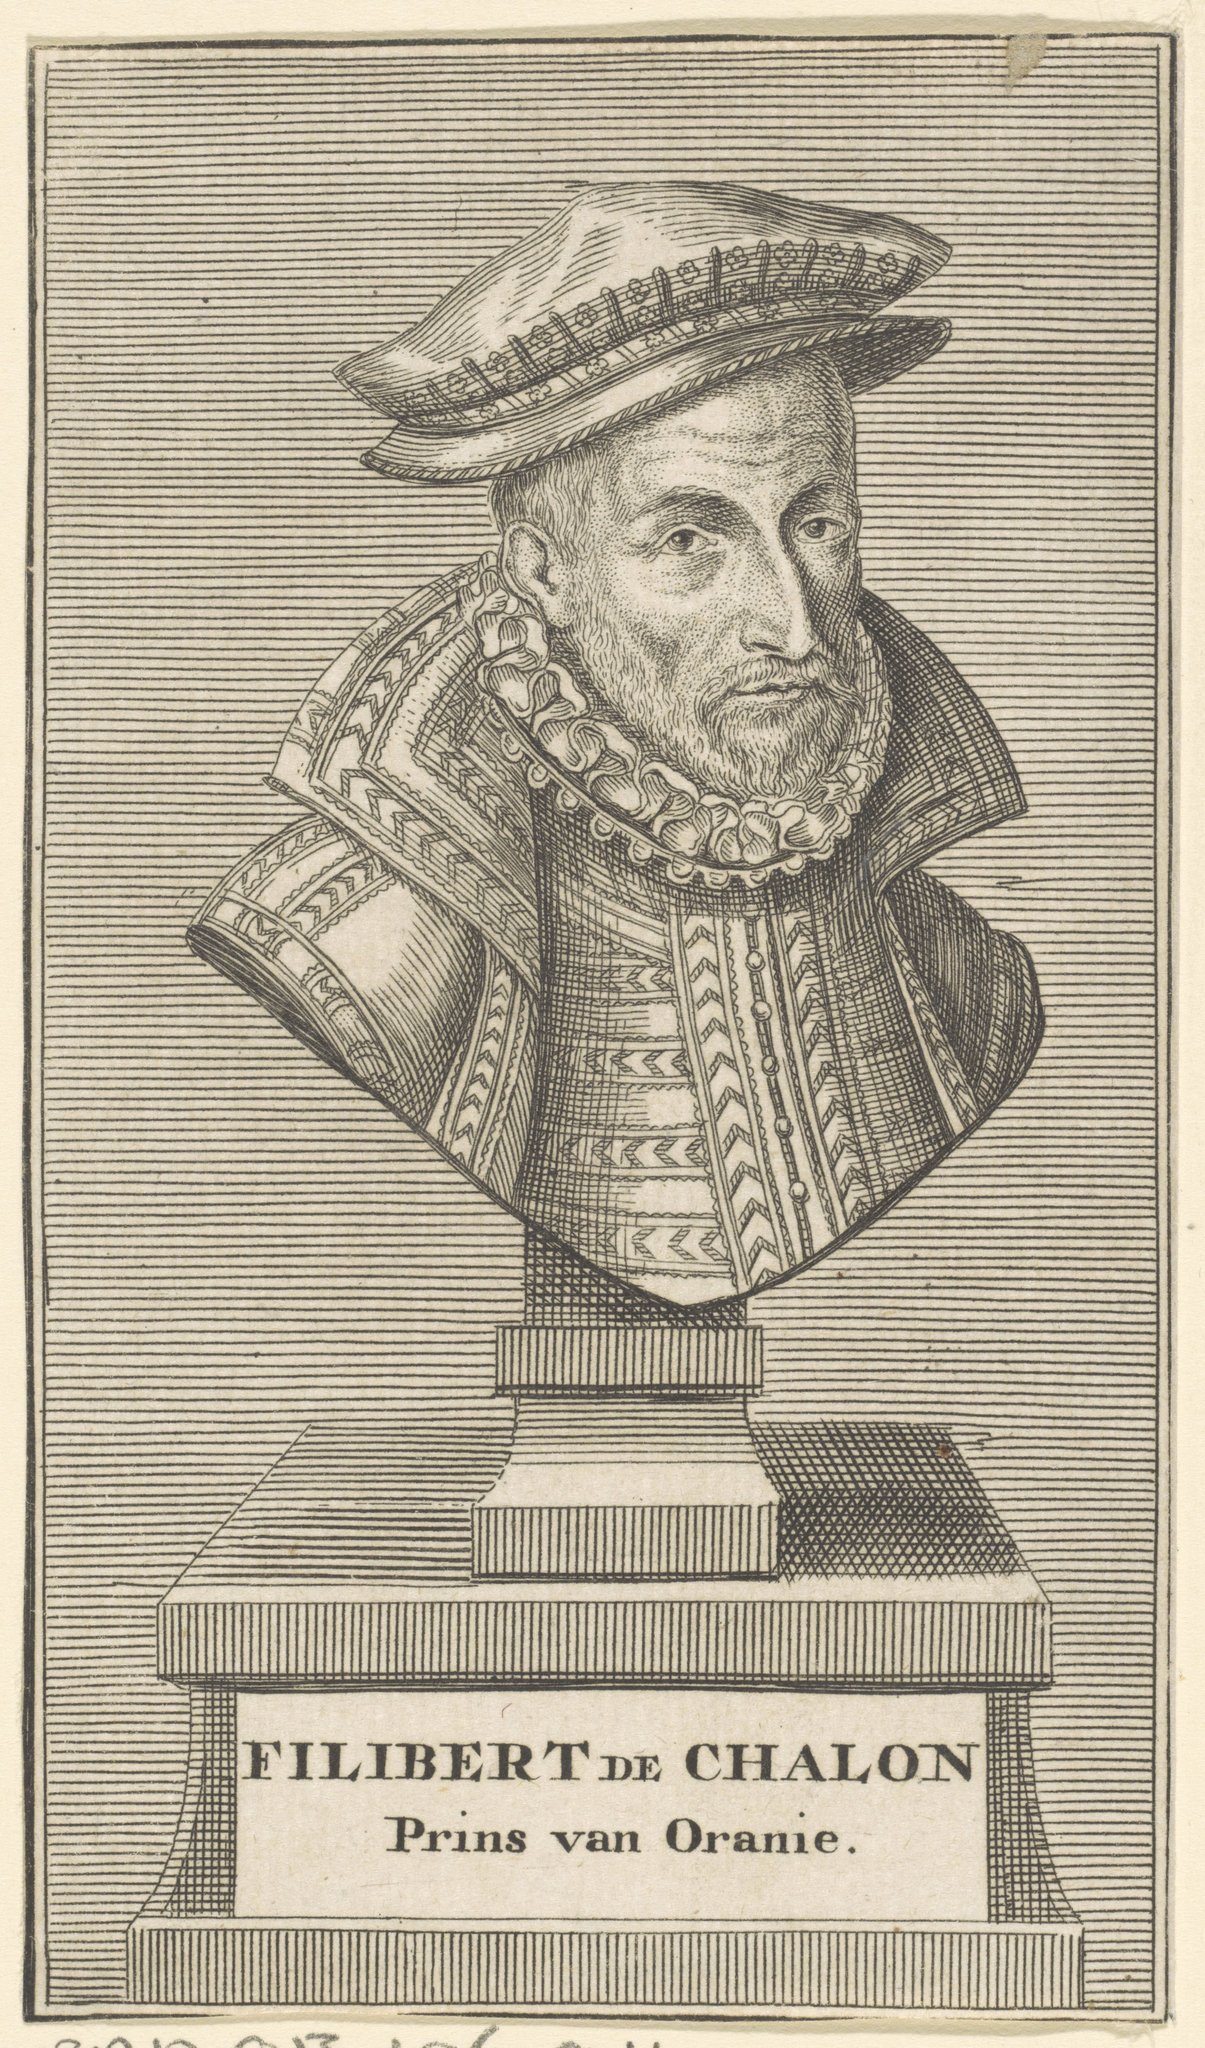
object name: print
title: Buste van Philibert van Châlon, prins van Oranje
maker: Anonymous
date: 1600-1699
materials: paper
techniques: engraving, etching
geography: low countries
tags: piece of sculpture, reproduction of a piece of sculpture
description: De hier vermelde titel verwijst naar de hoogst verkregen titel van de geportretteerde, niet per se naar de titel die de geportretteerde op deze voorstelling draagt.